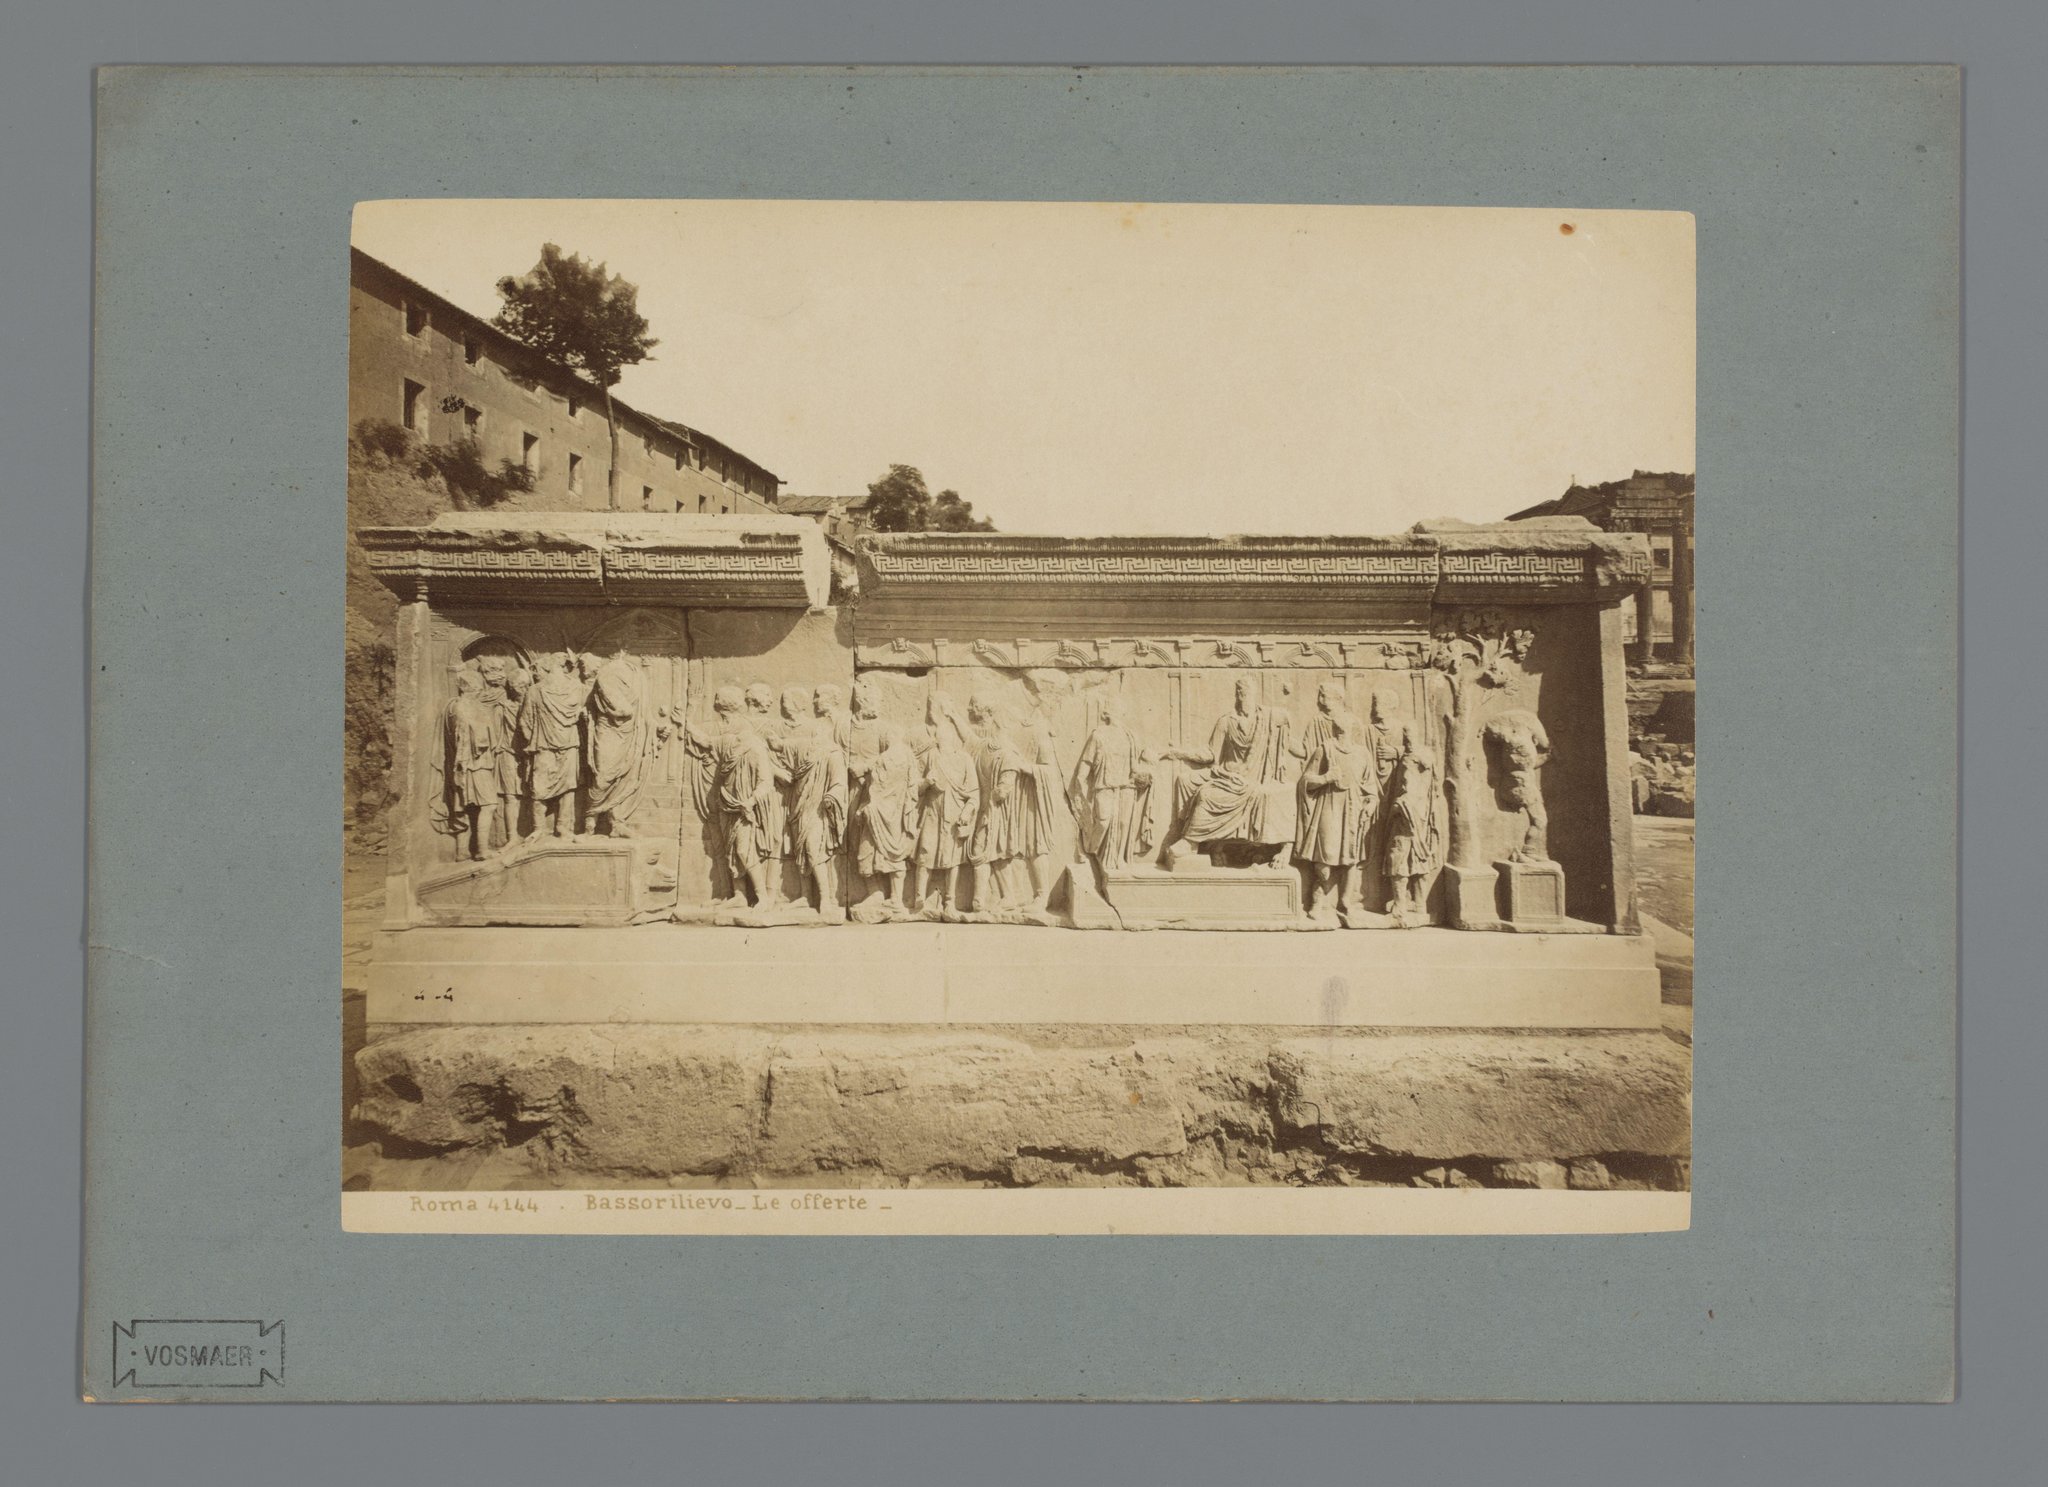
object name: photograph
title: Bassorilievo Le offerte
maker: Anonymous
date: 1851-1890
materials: cardboard, paper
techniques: albumen print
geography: rome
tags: art (+ relief ~ sculpture), rome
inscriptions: number: ‘4-4’, collector's mark: ‘VOSMAER’, number: ‘4144’